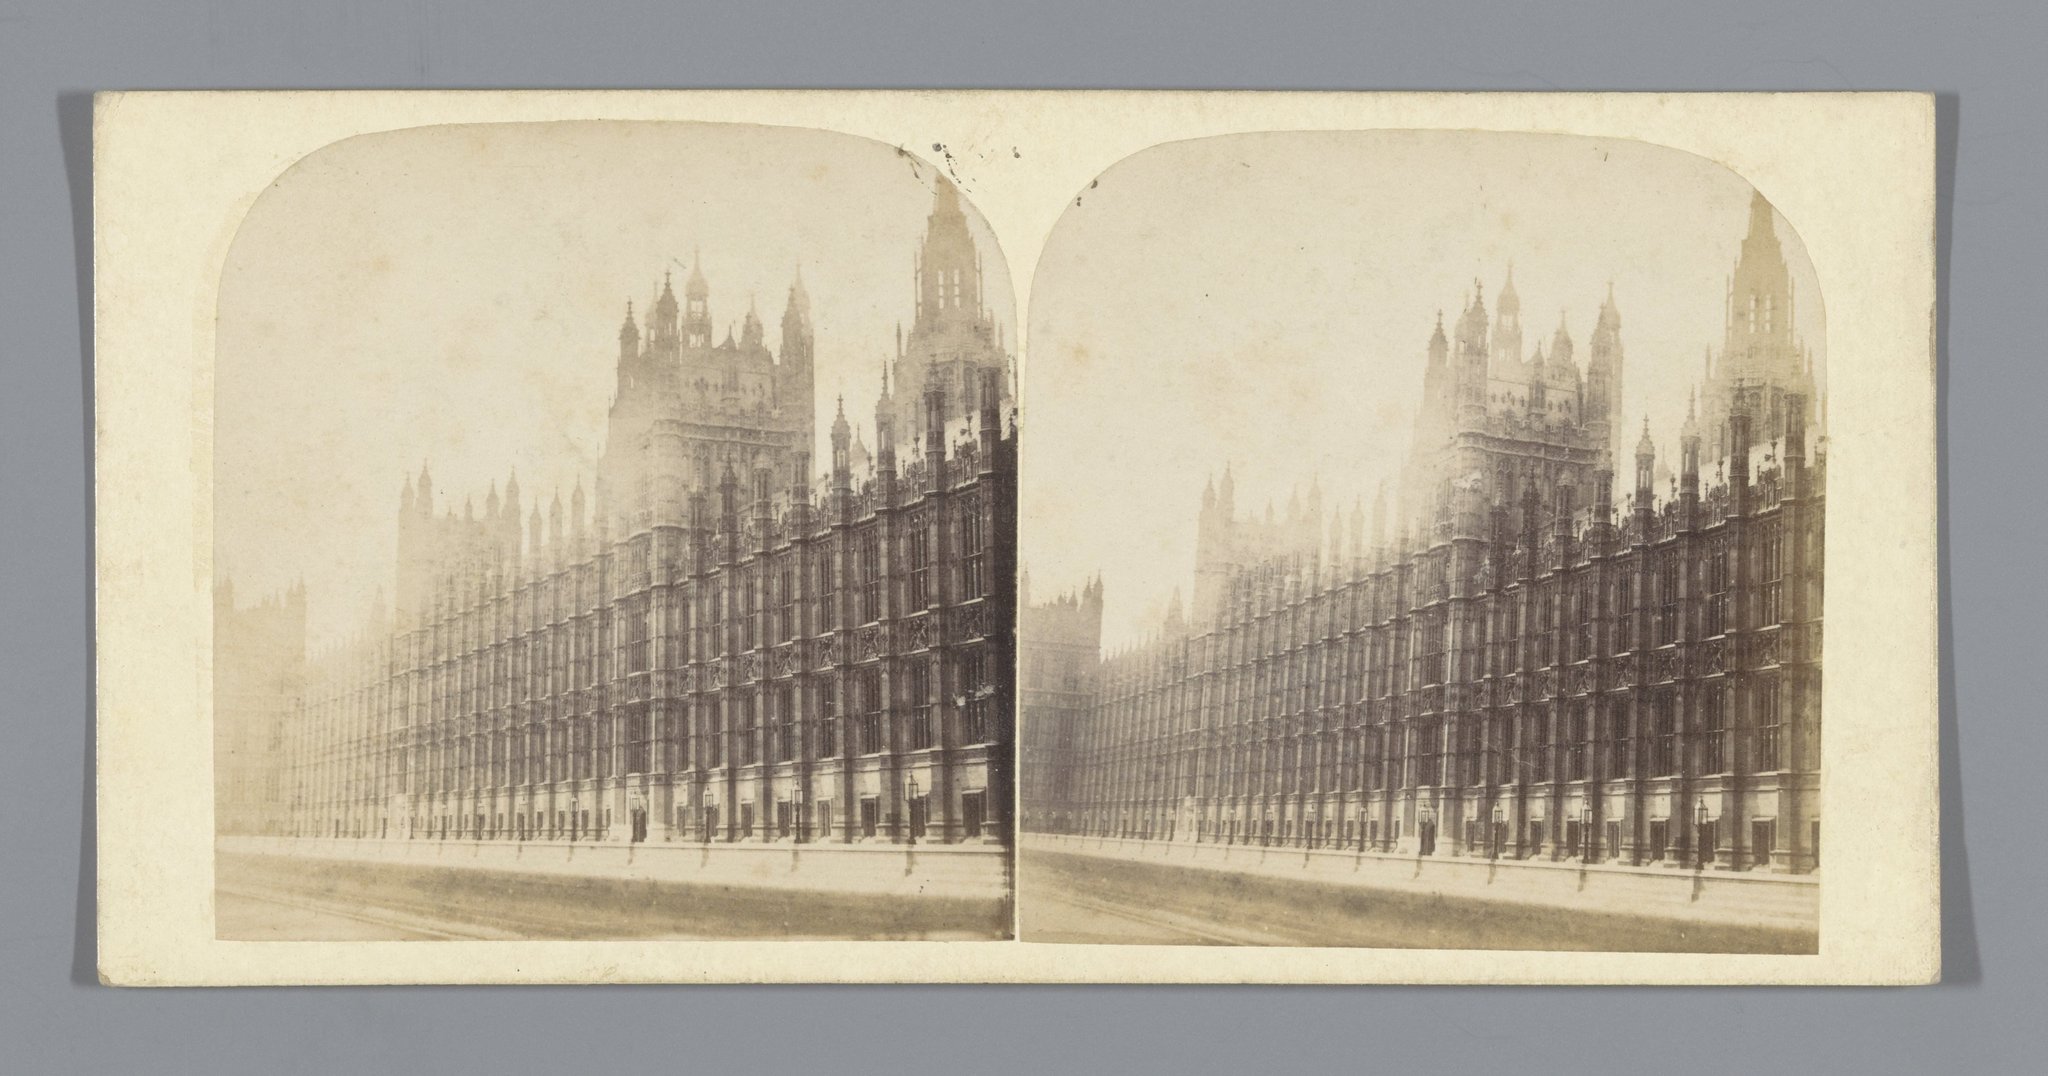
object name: stereograph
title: London Views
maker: Anonymous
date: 1860-1865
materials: cardboard, photographic support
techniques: albumen print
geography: london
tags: lower house, parliament, chamber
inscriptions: inscription